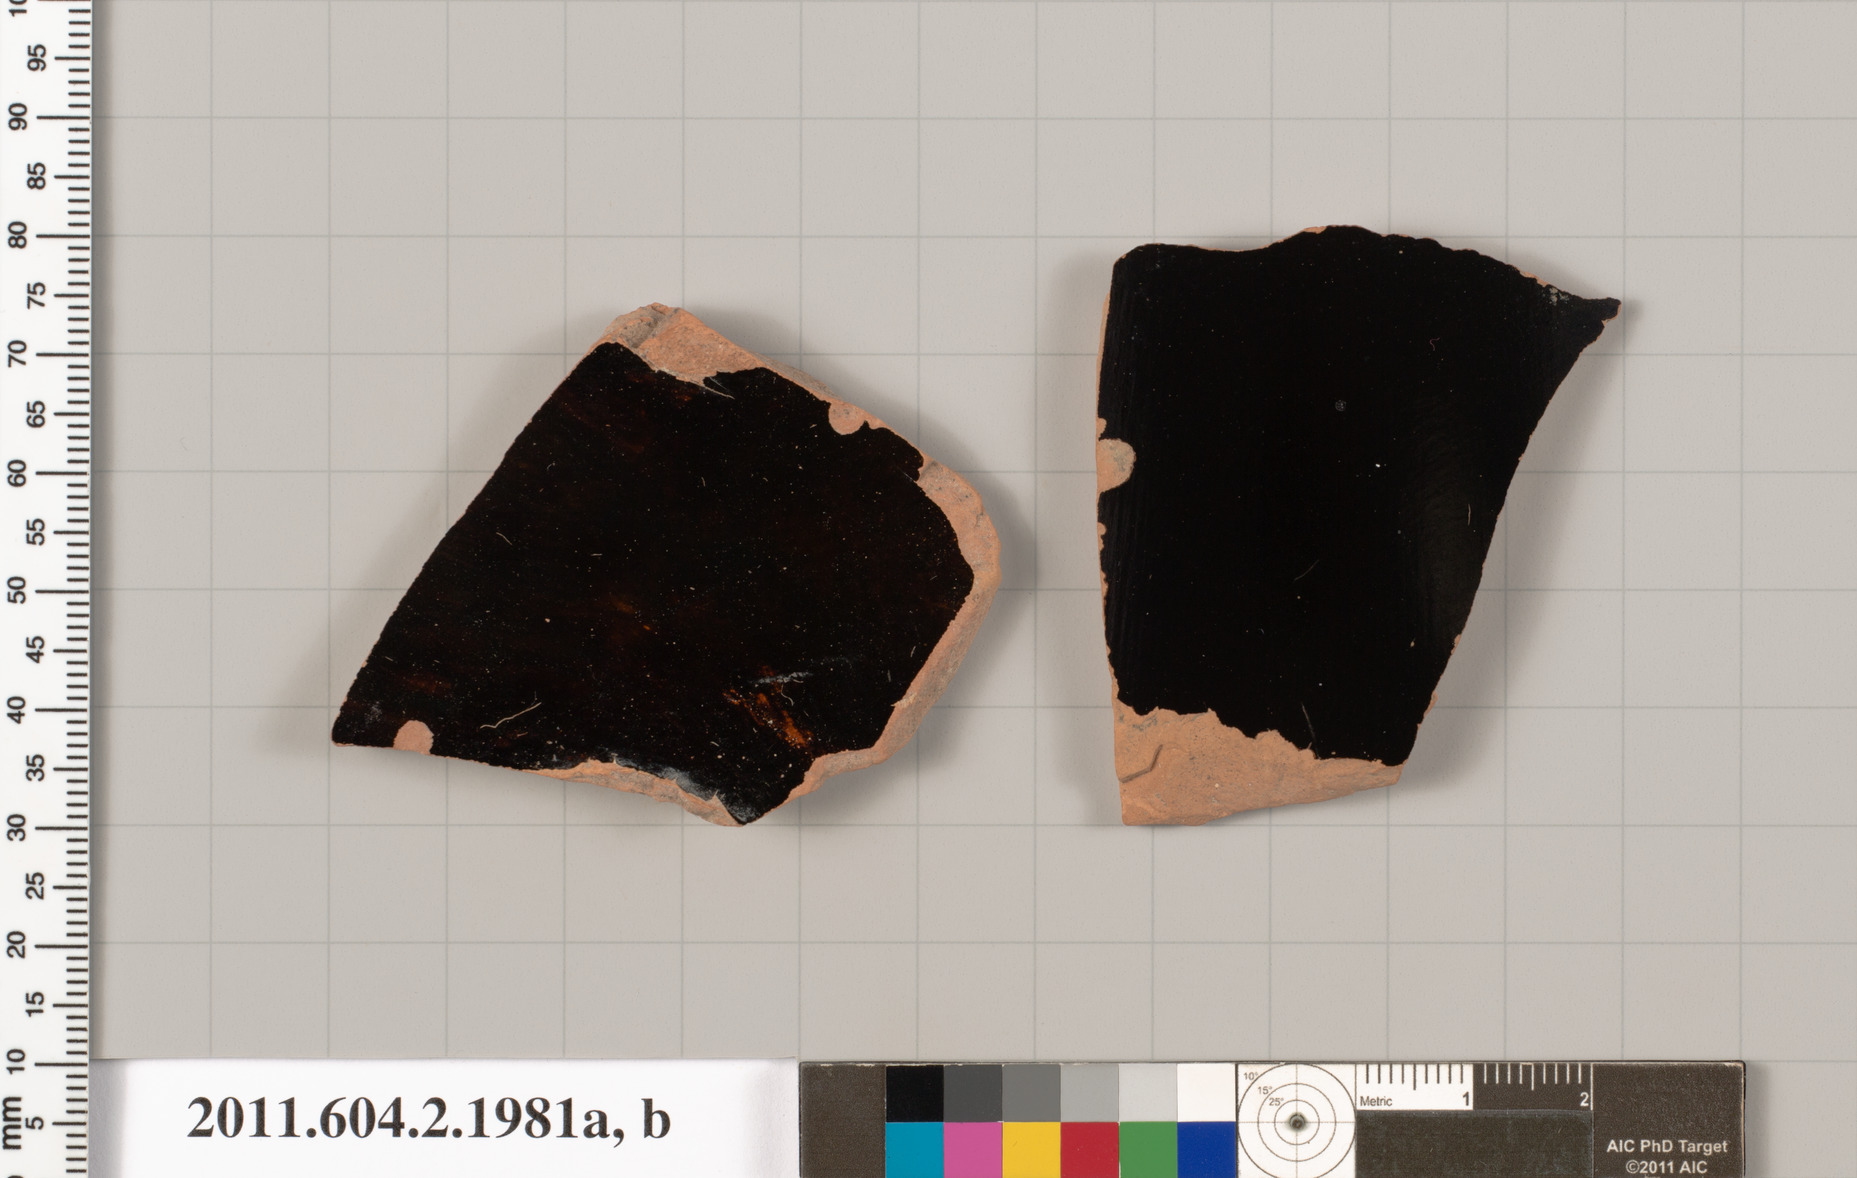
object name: pot fragment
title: Terracotta fragments of pots; unglazed on the inside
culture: greek, attic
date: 500-401 BCE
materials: terracotta